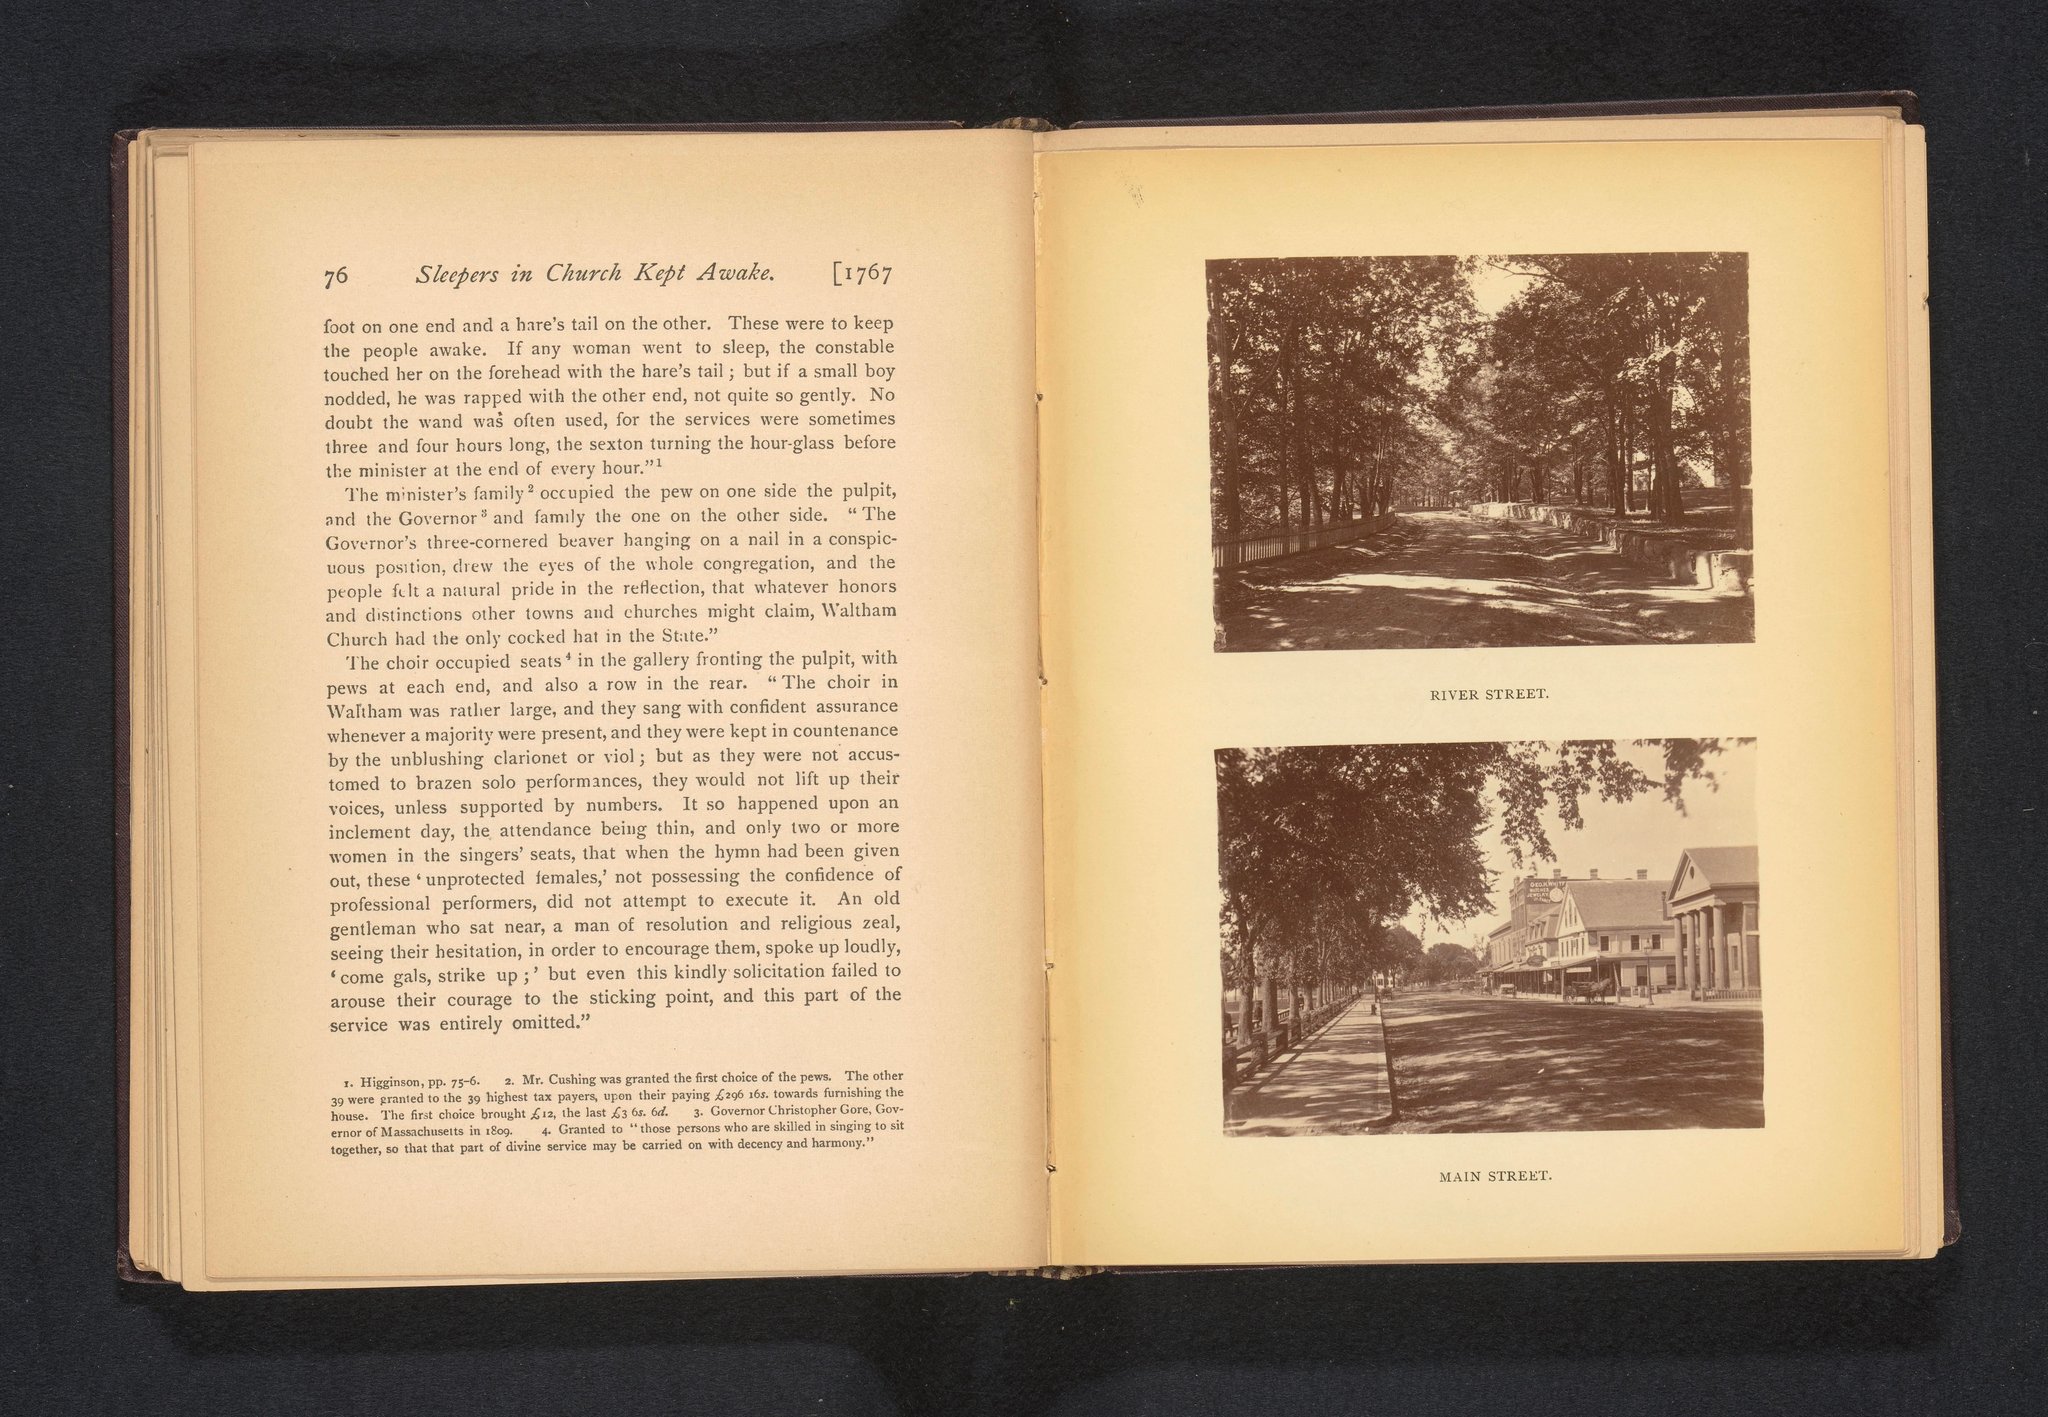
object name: page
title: Gezicht op River Street in Waltham, Massachusetts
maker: thomas r. lewis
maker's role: publisher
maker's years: 1845-1901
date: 1874-1879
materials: photographic support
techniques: albumen print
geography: waltham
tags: street